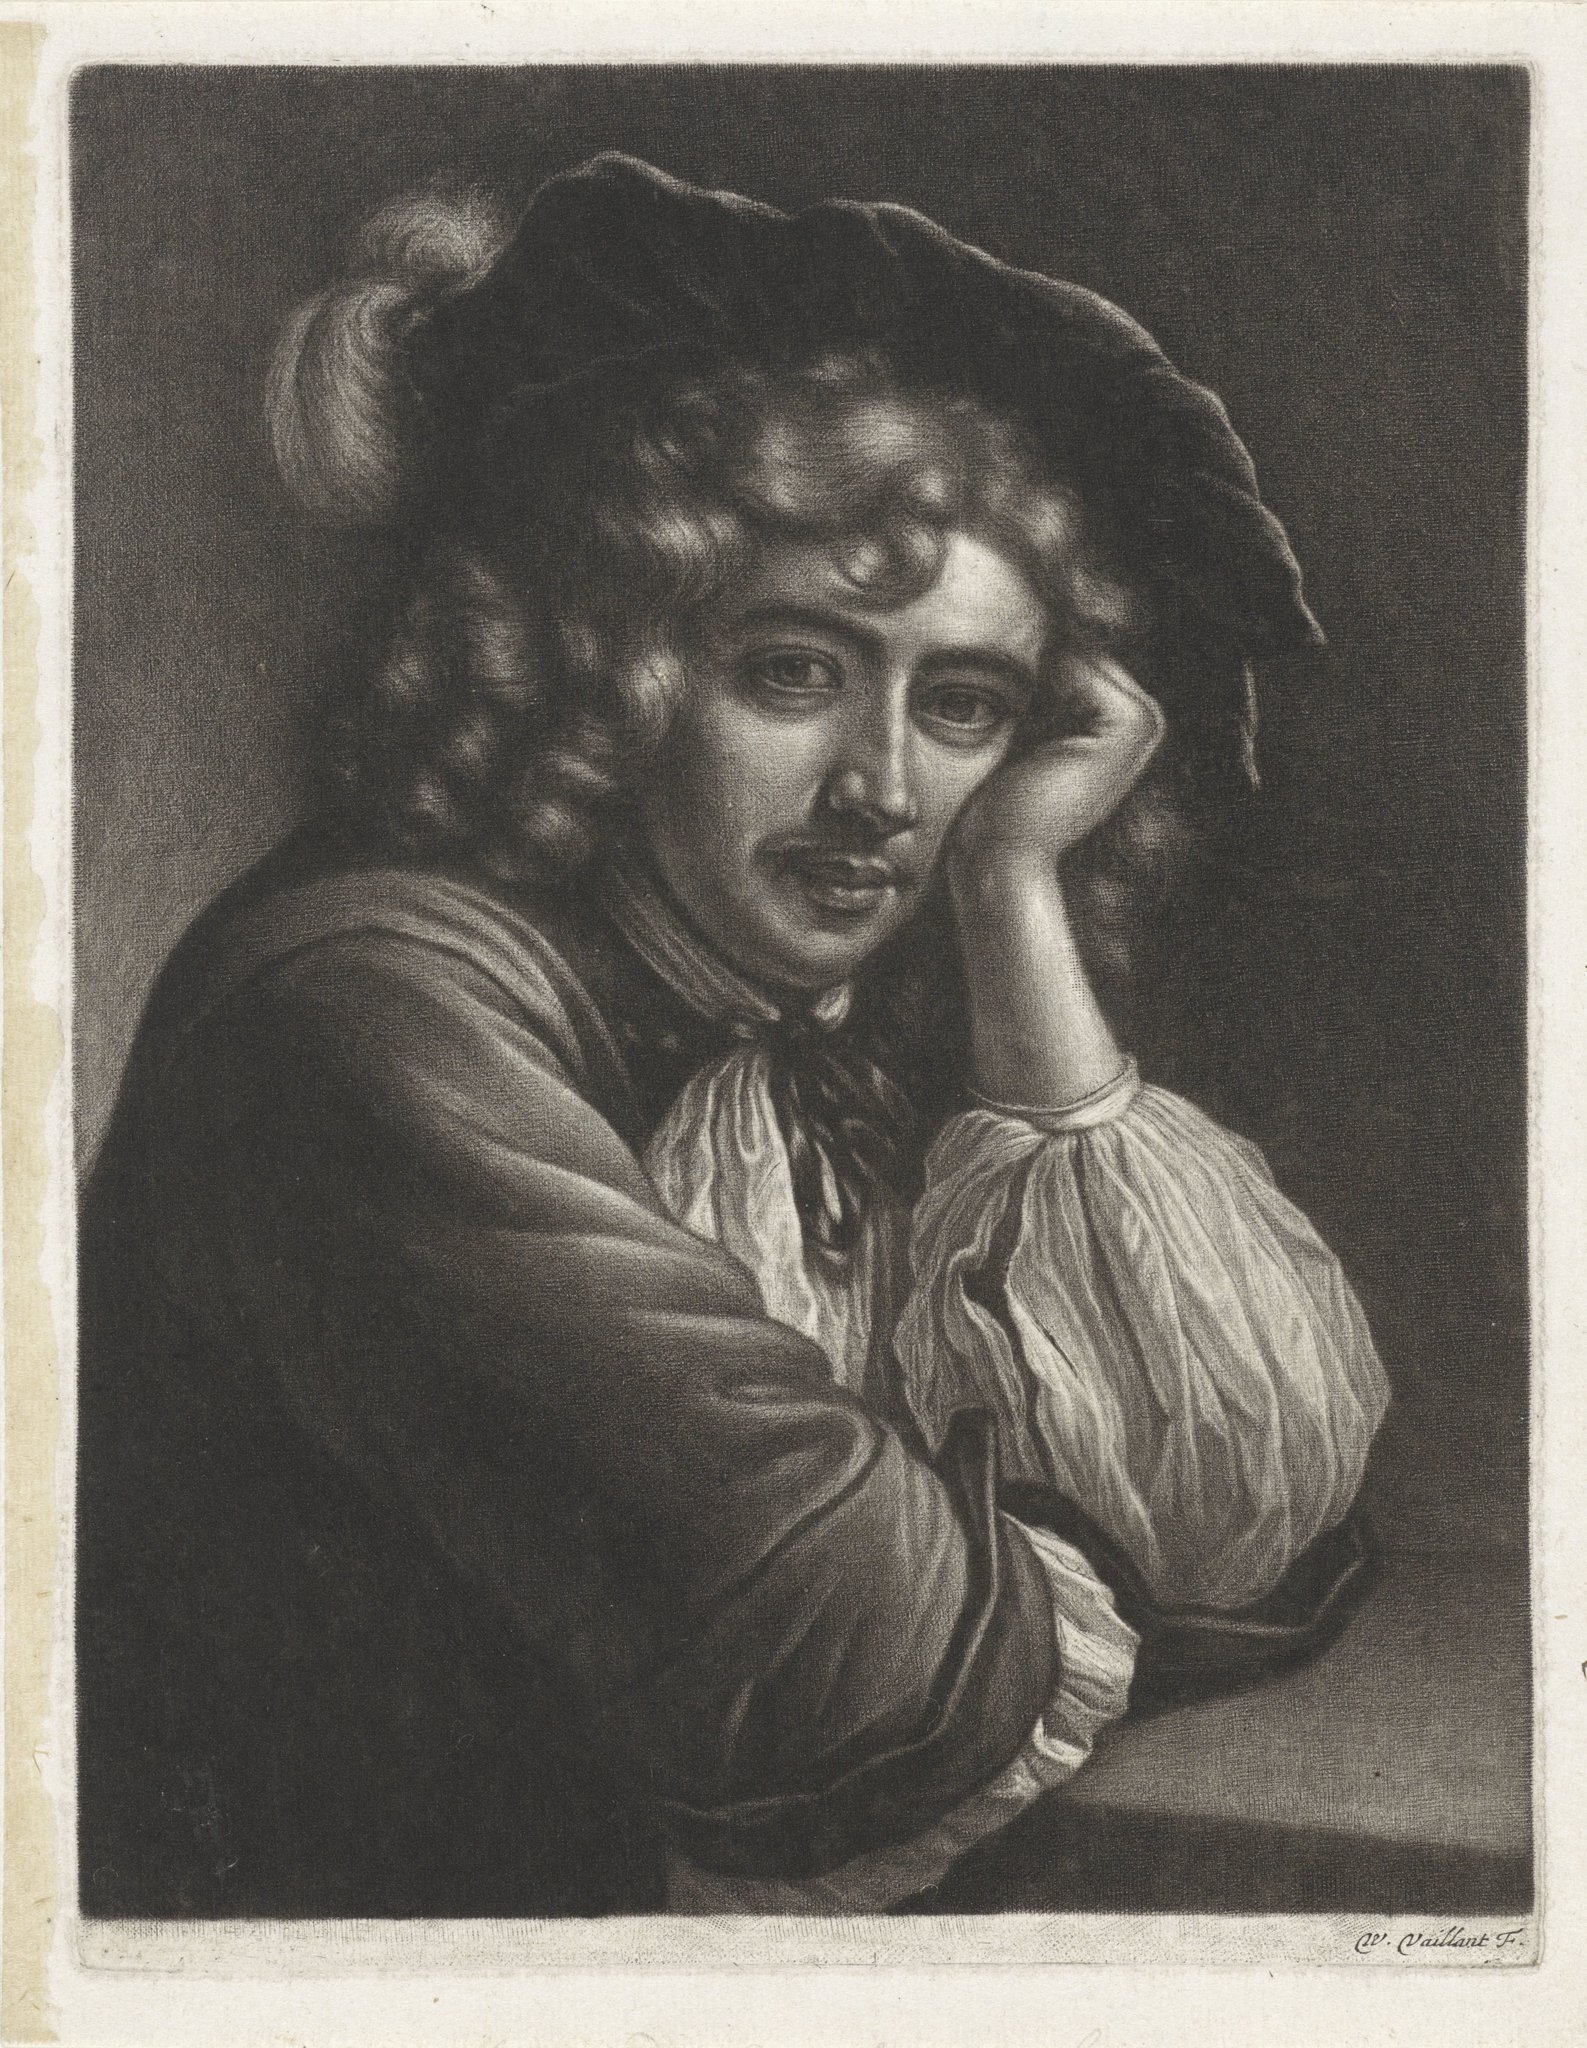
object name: print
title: Portret van Prins Ruprecht van de Palts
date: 1658-1677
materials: paper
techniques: mezzotint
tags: prague, london, painter, print maker, draughtsman, prinz ruprecht, head-gear: hat (+ men's clothes)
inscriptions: collector's mark: Lugt 2228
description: Prins Ruprecht van de Palts, neef van koning Karel I van Engeland en commandant van de royalistische cavalerie tijdens de Engelse Burgeroorlog. Daarnaast was hij uitvinder en prentmaker.